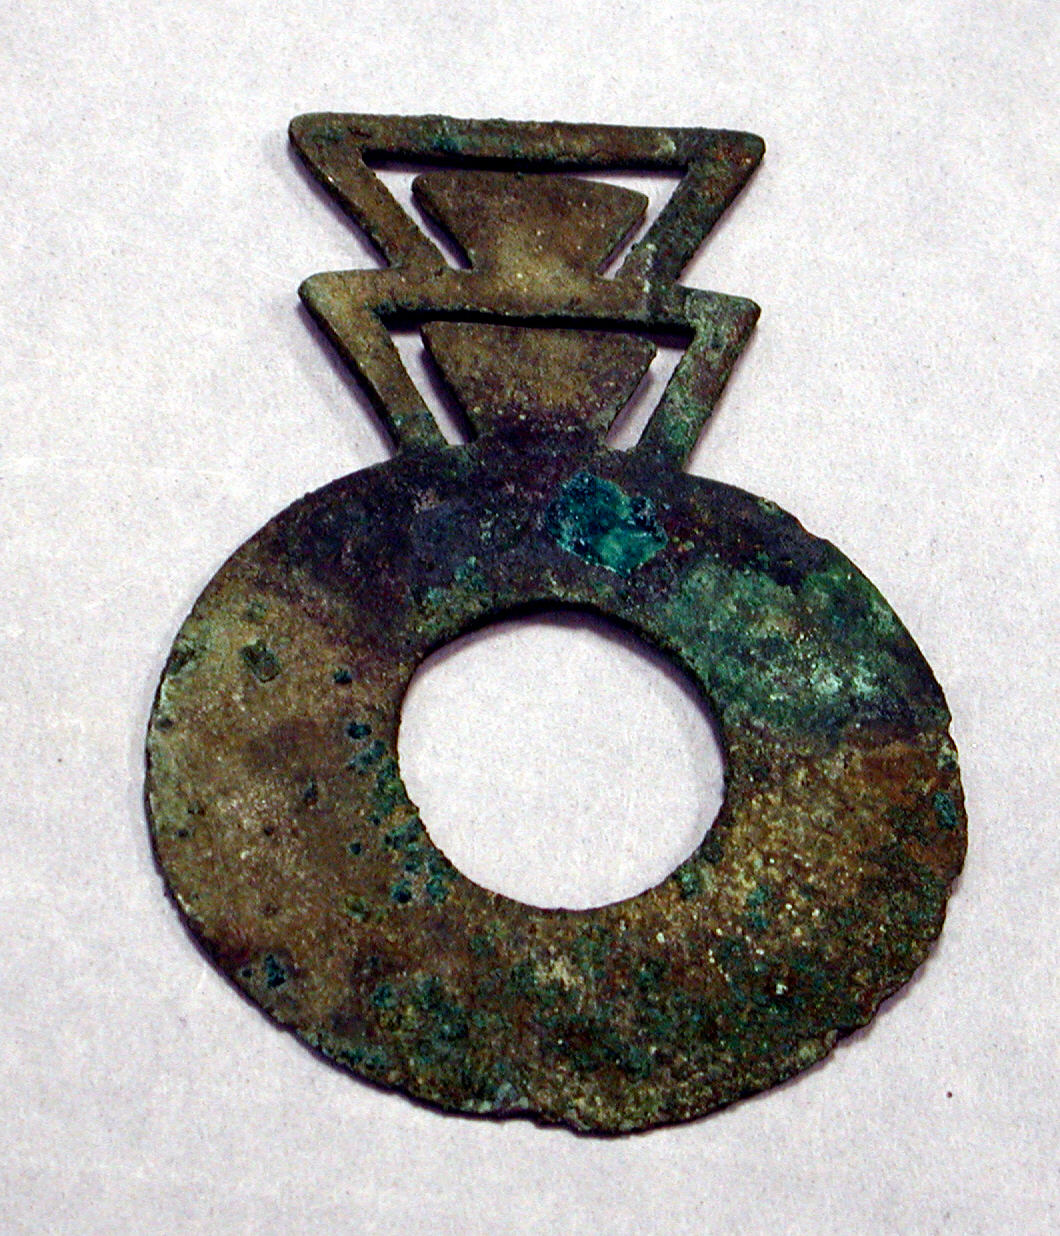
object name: ornament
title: Copper Disk Ornament with Triangles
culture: peruvian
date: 901-1500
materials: copper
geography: peru